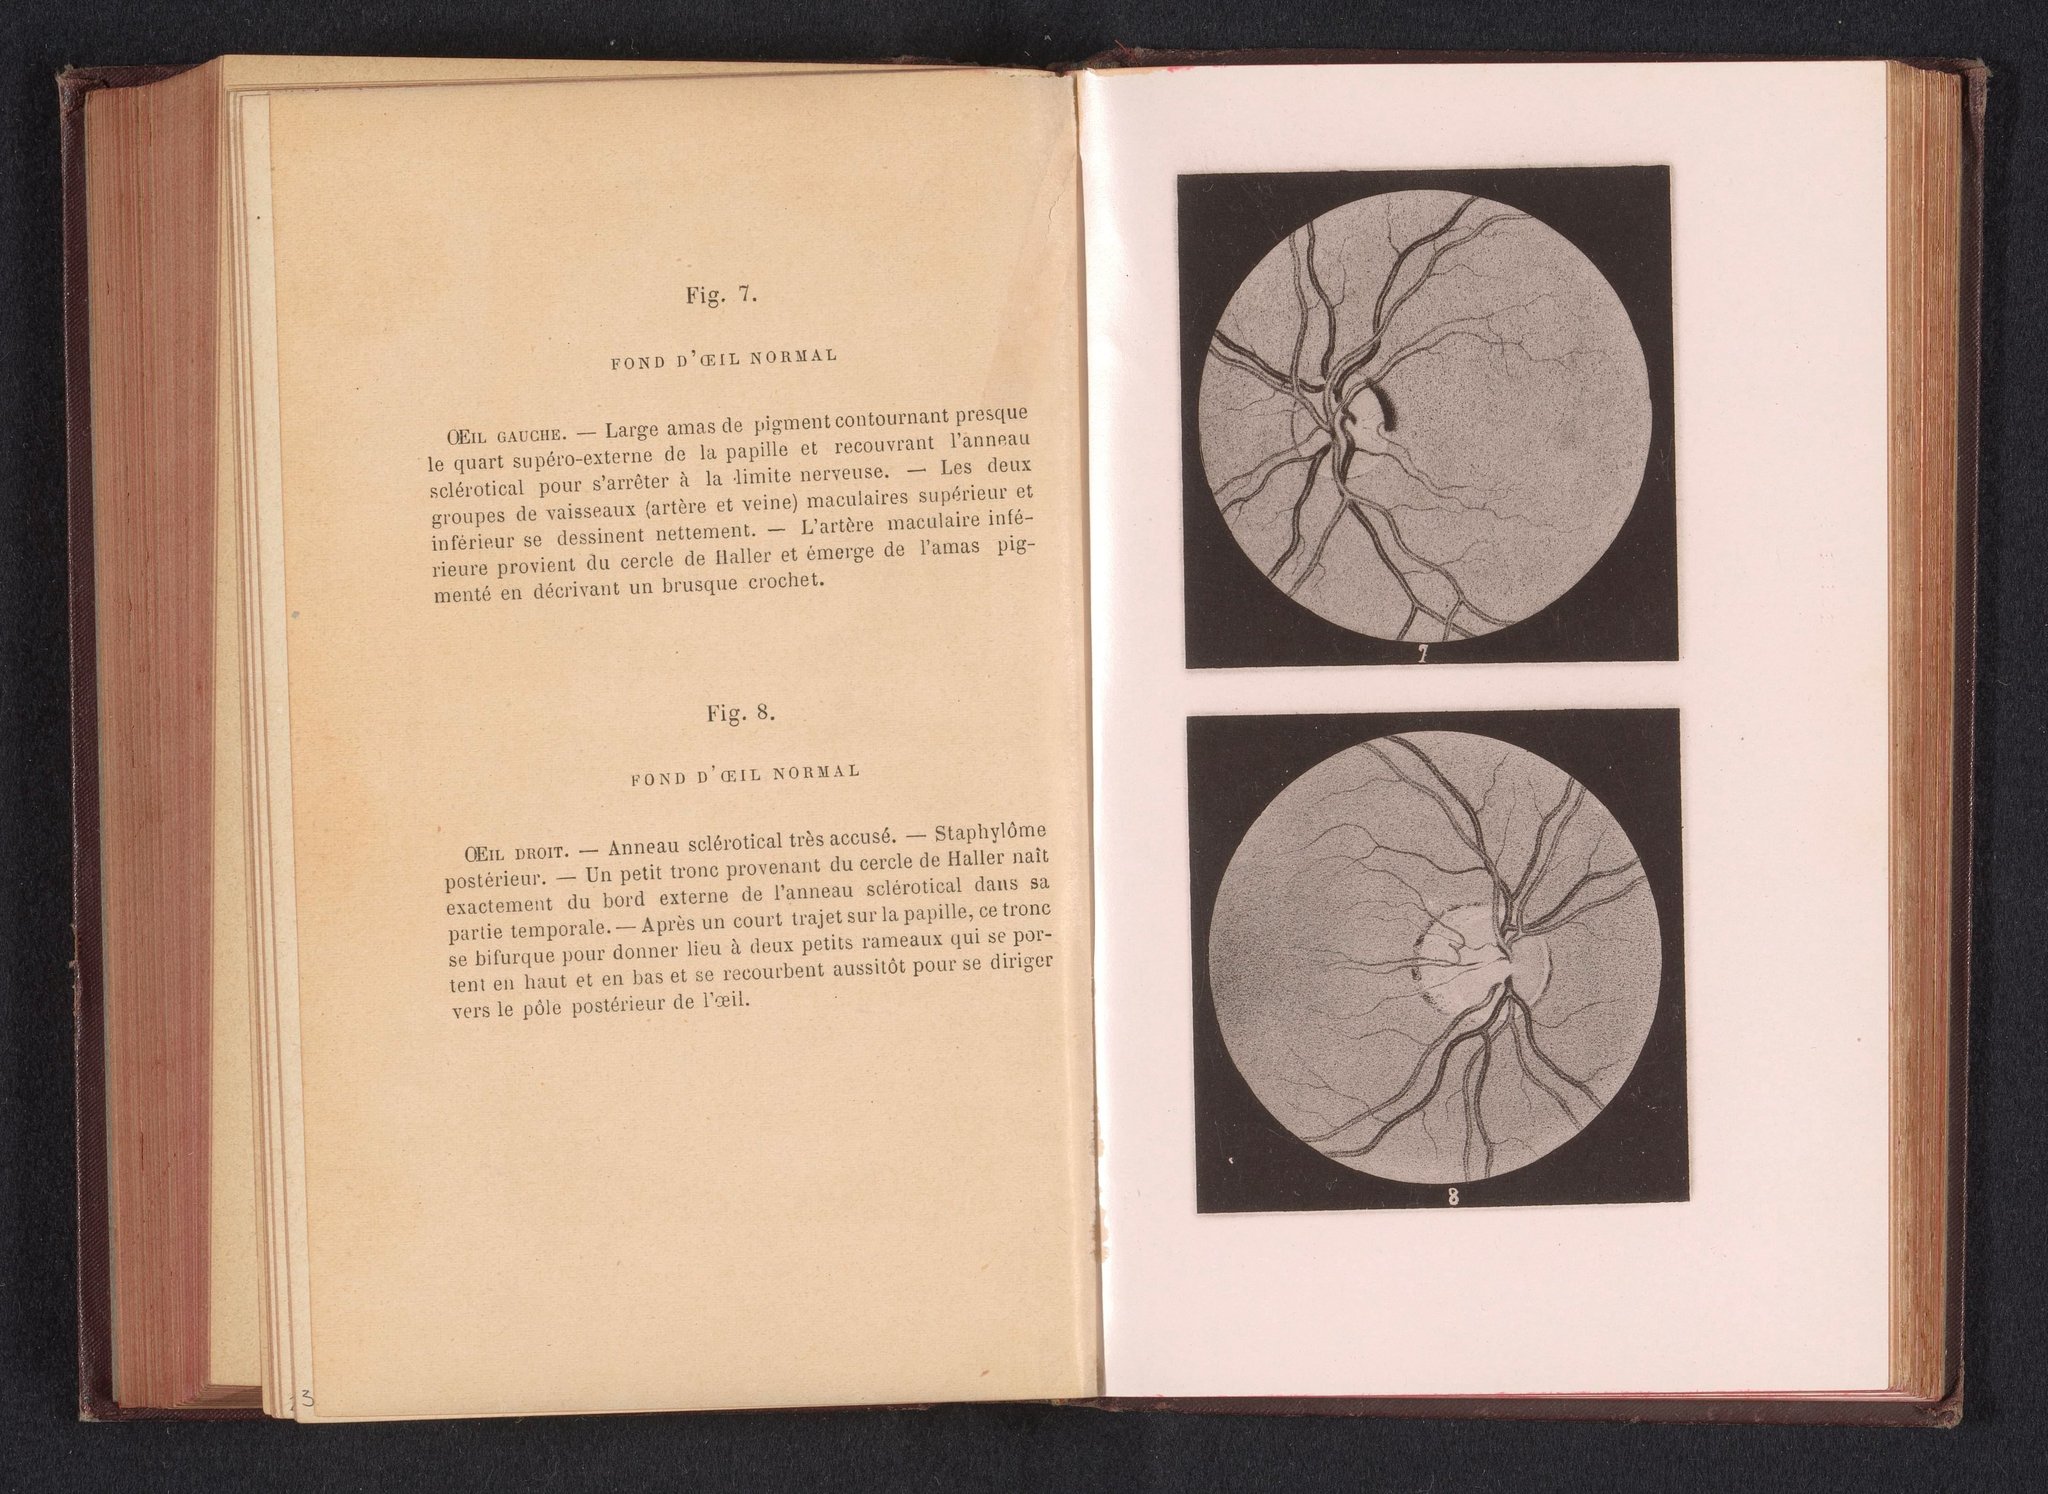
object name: reproduction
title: Fotoreproductie van twee anatomische tekeningen van een normaal oog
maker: Anonymous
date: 1871-1891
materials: paper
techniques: photograph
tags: anatomy (non-medical), eyes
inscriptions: inscription: ‘Fig. 7. Fond d'oeil normal Fig. 8. Fond d'oeil normal’